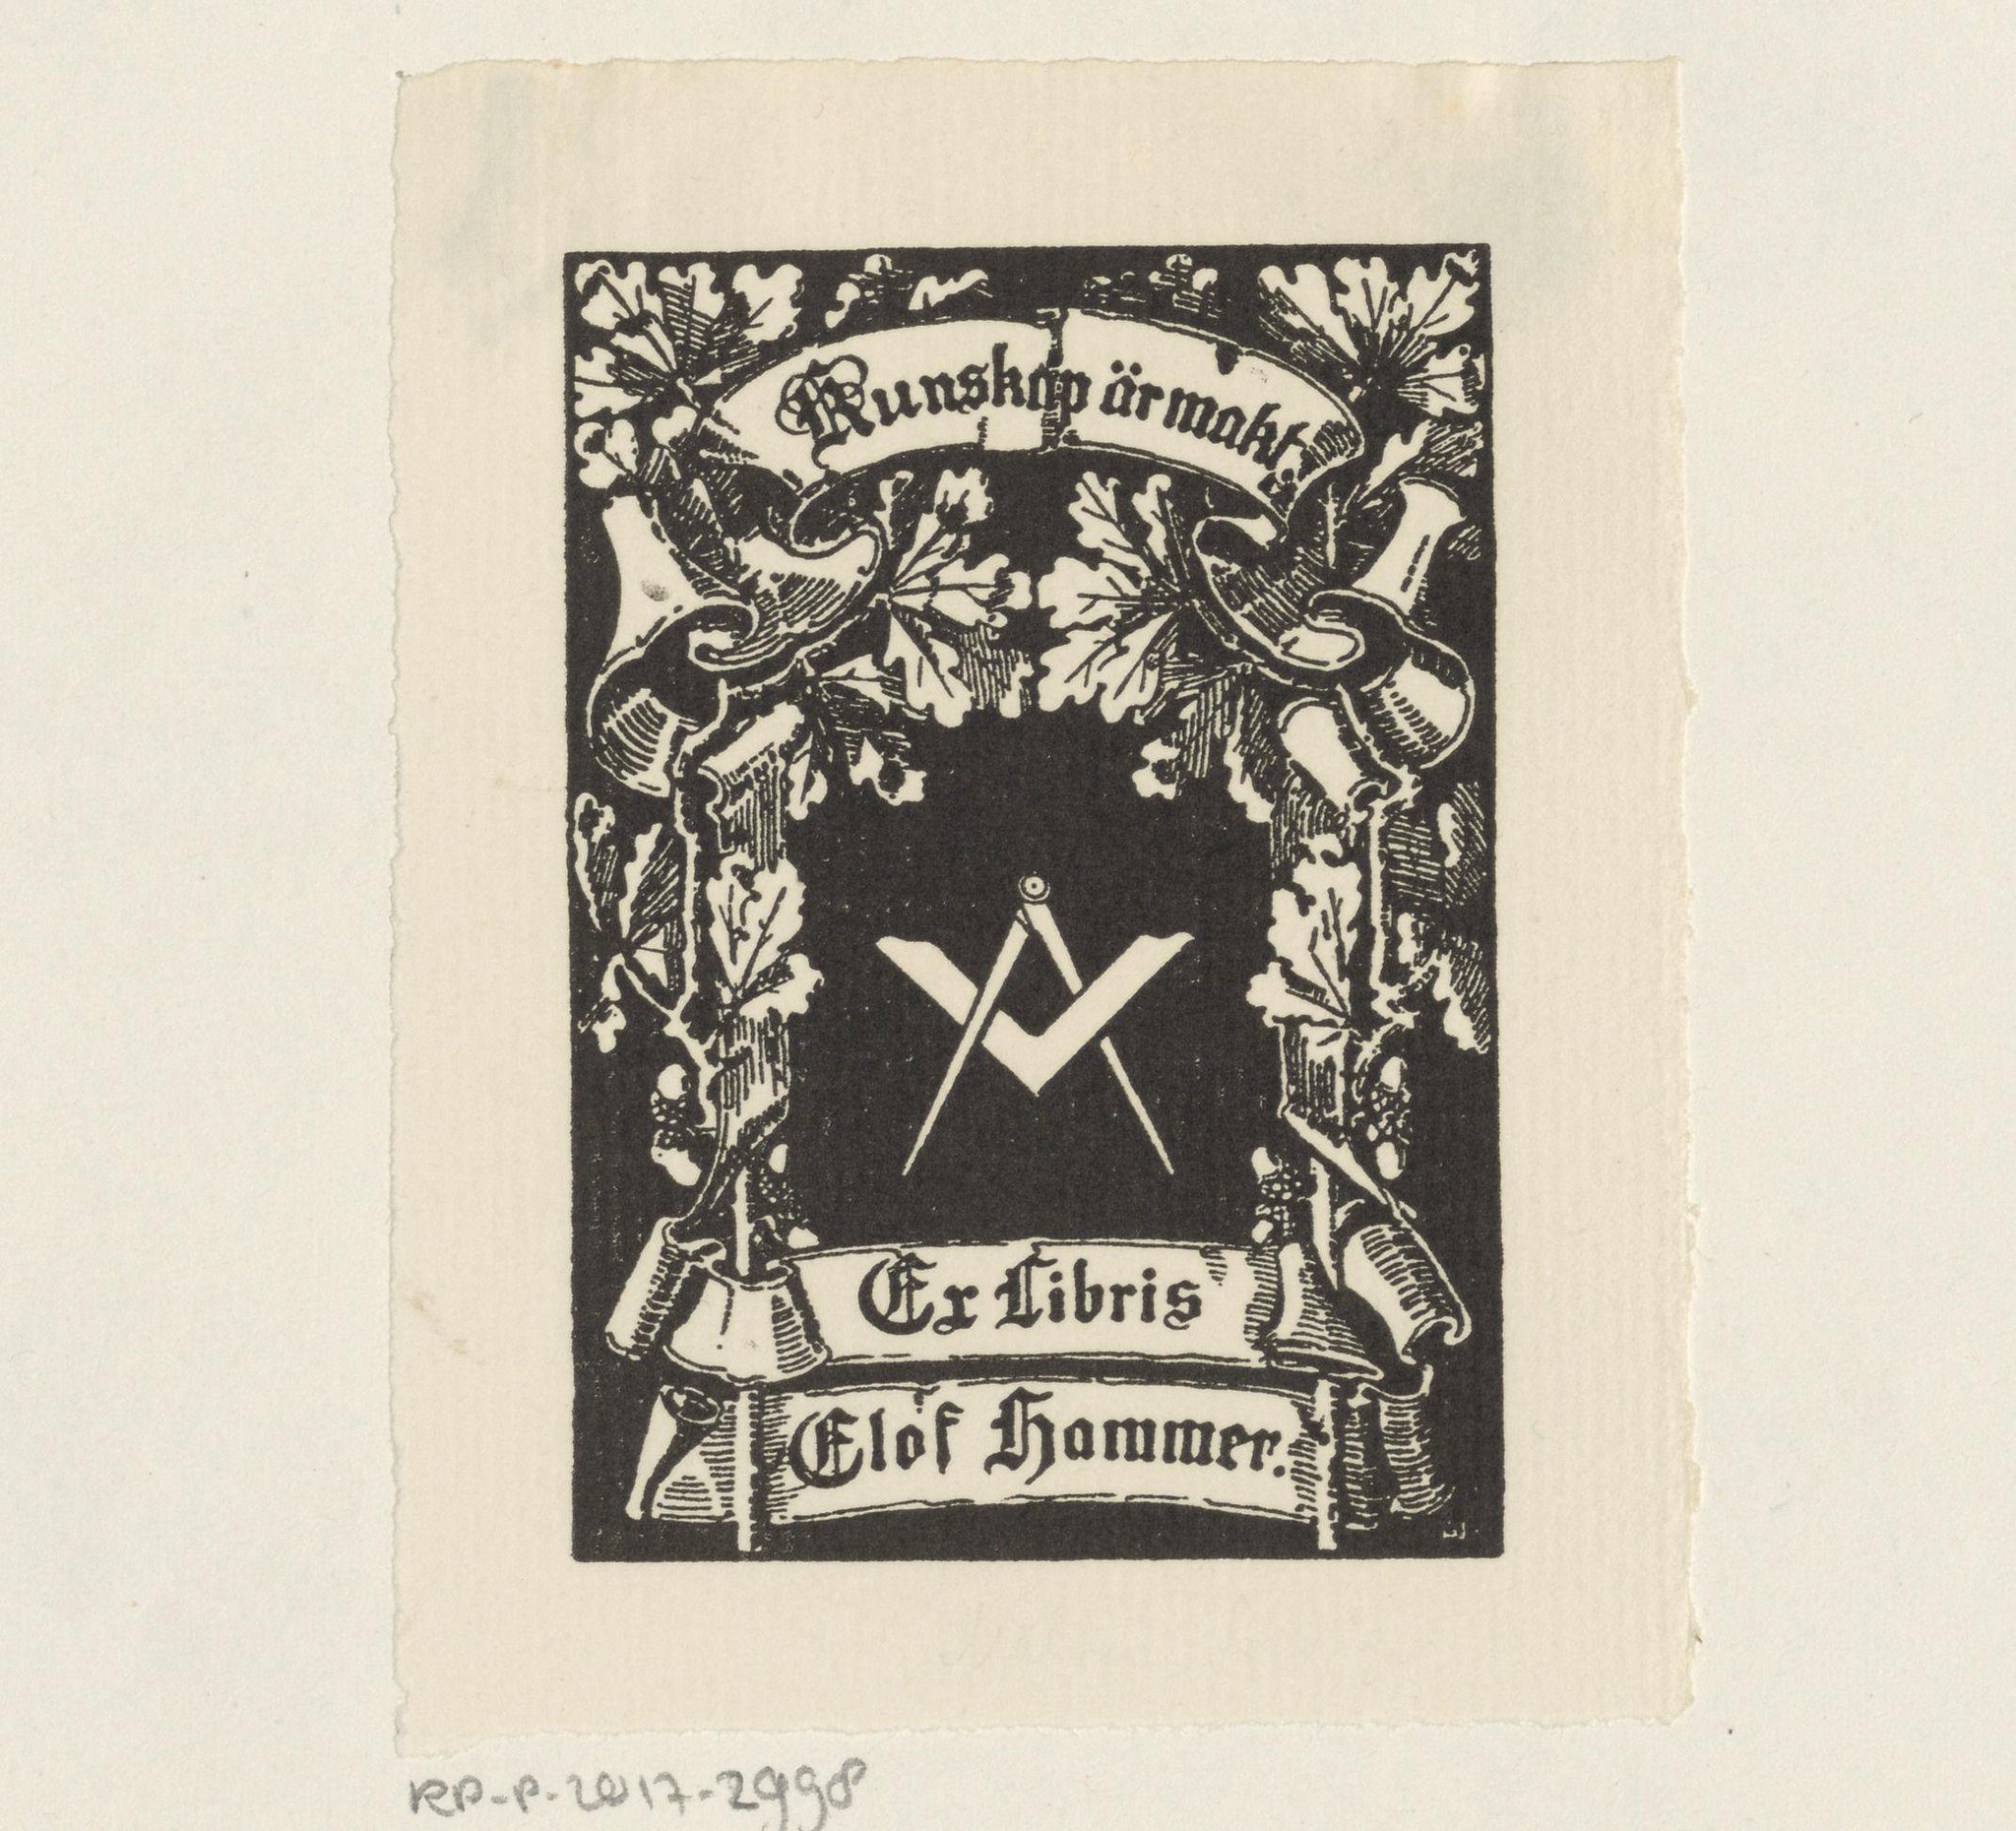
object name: bookplate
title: Ex libris van Elof Hammer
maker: Anonymous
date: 1906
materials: paper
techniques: printing block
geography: sweden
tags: trees: oak, miscellaneous religions, cults and doctrines: freemasonry